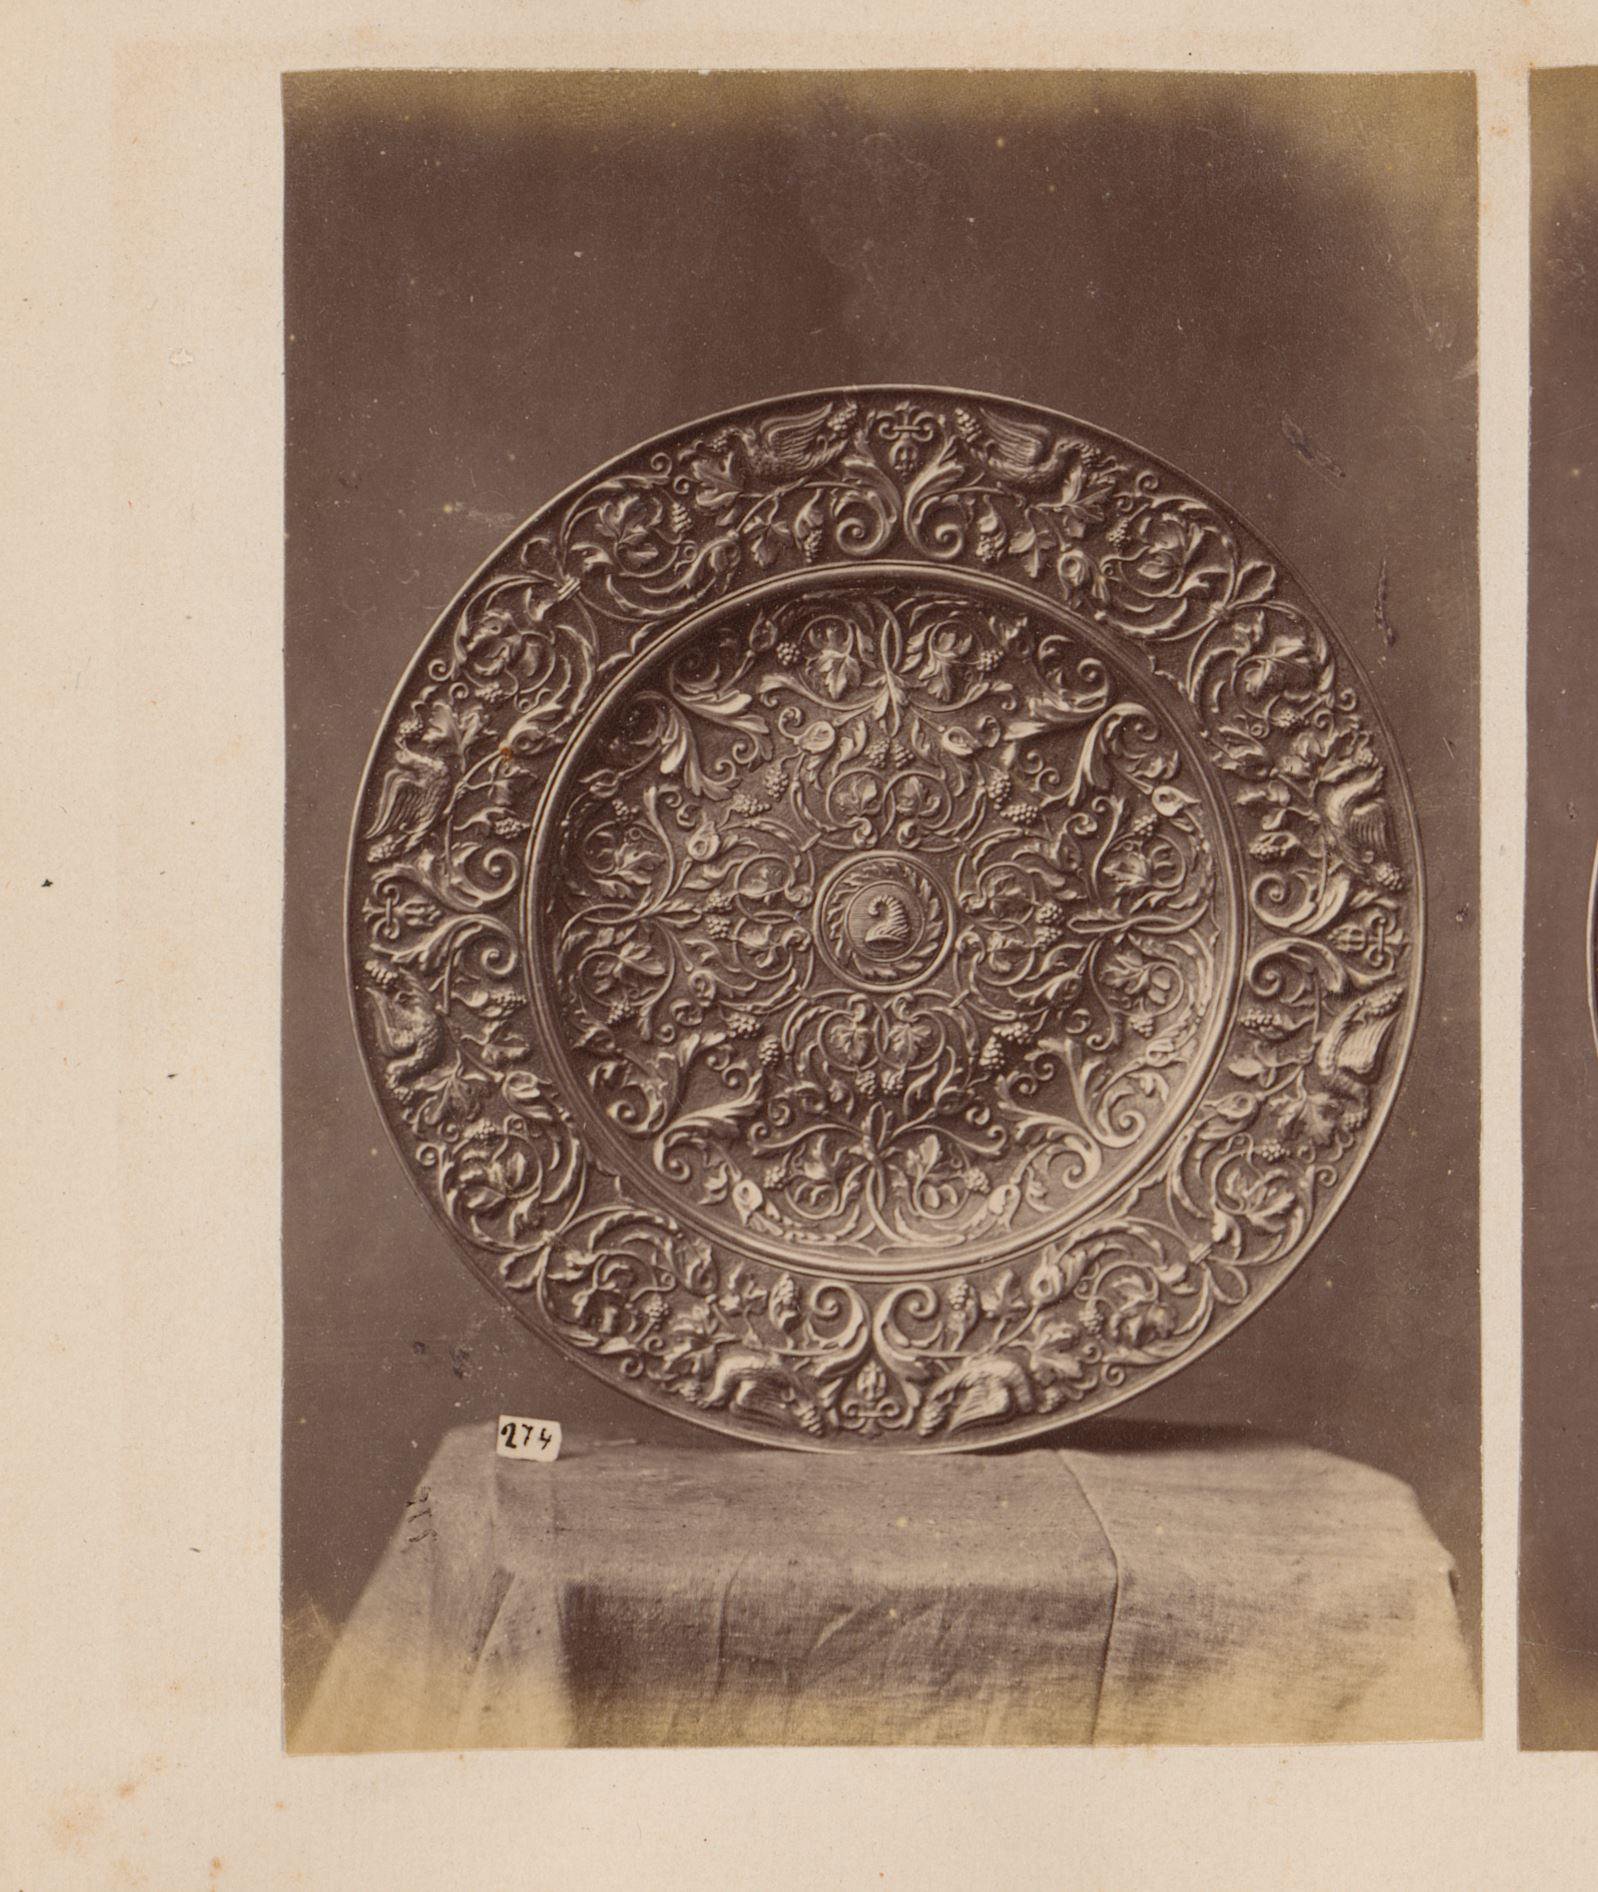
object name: page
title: Metalen bord uit de 16de eeuw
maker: Anonymous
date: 1860-1885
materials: photographic support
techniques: albumen print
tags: dish, plate, saucer